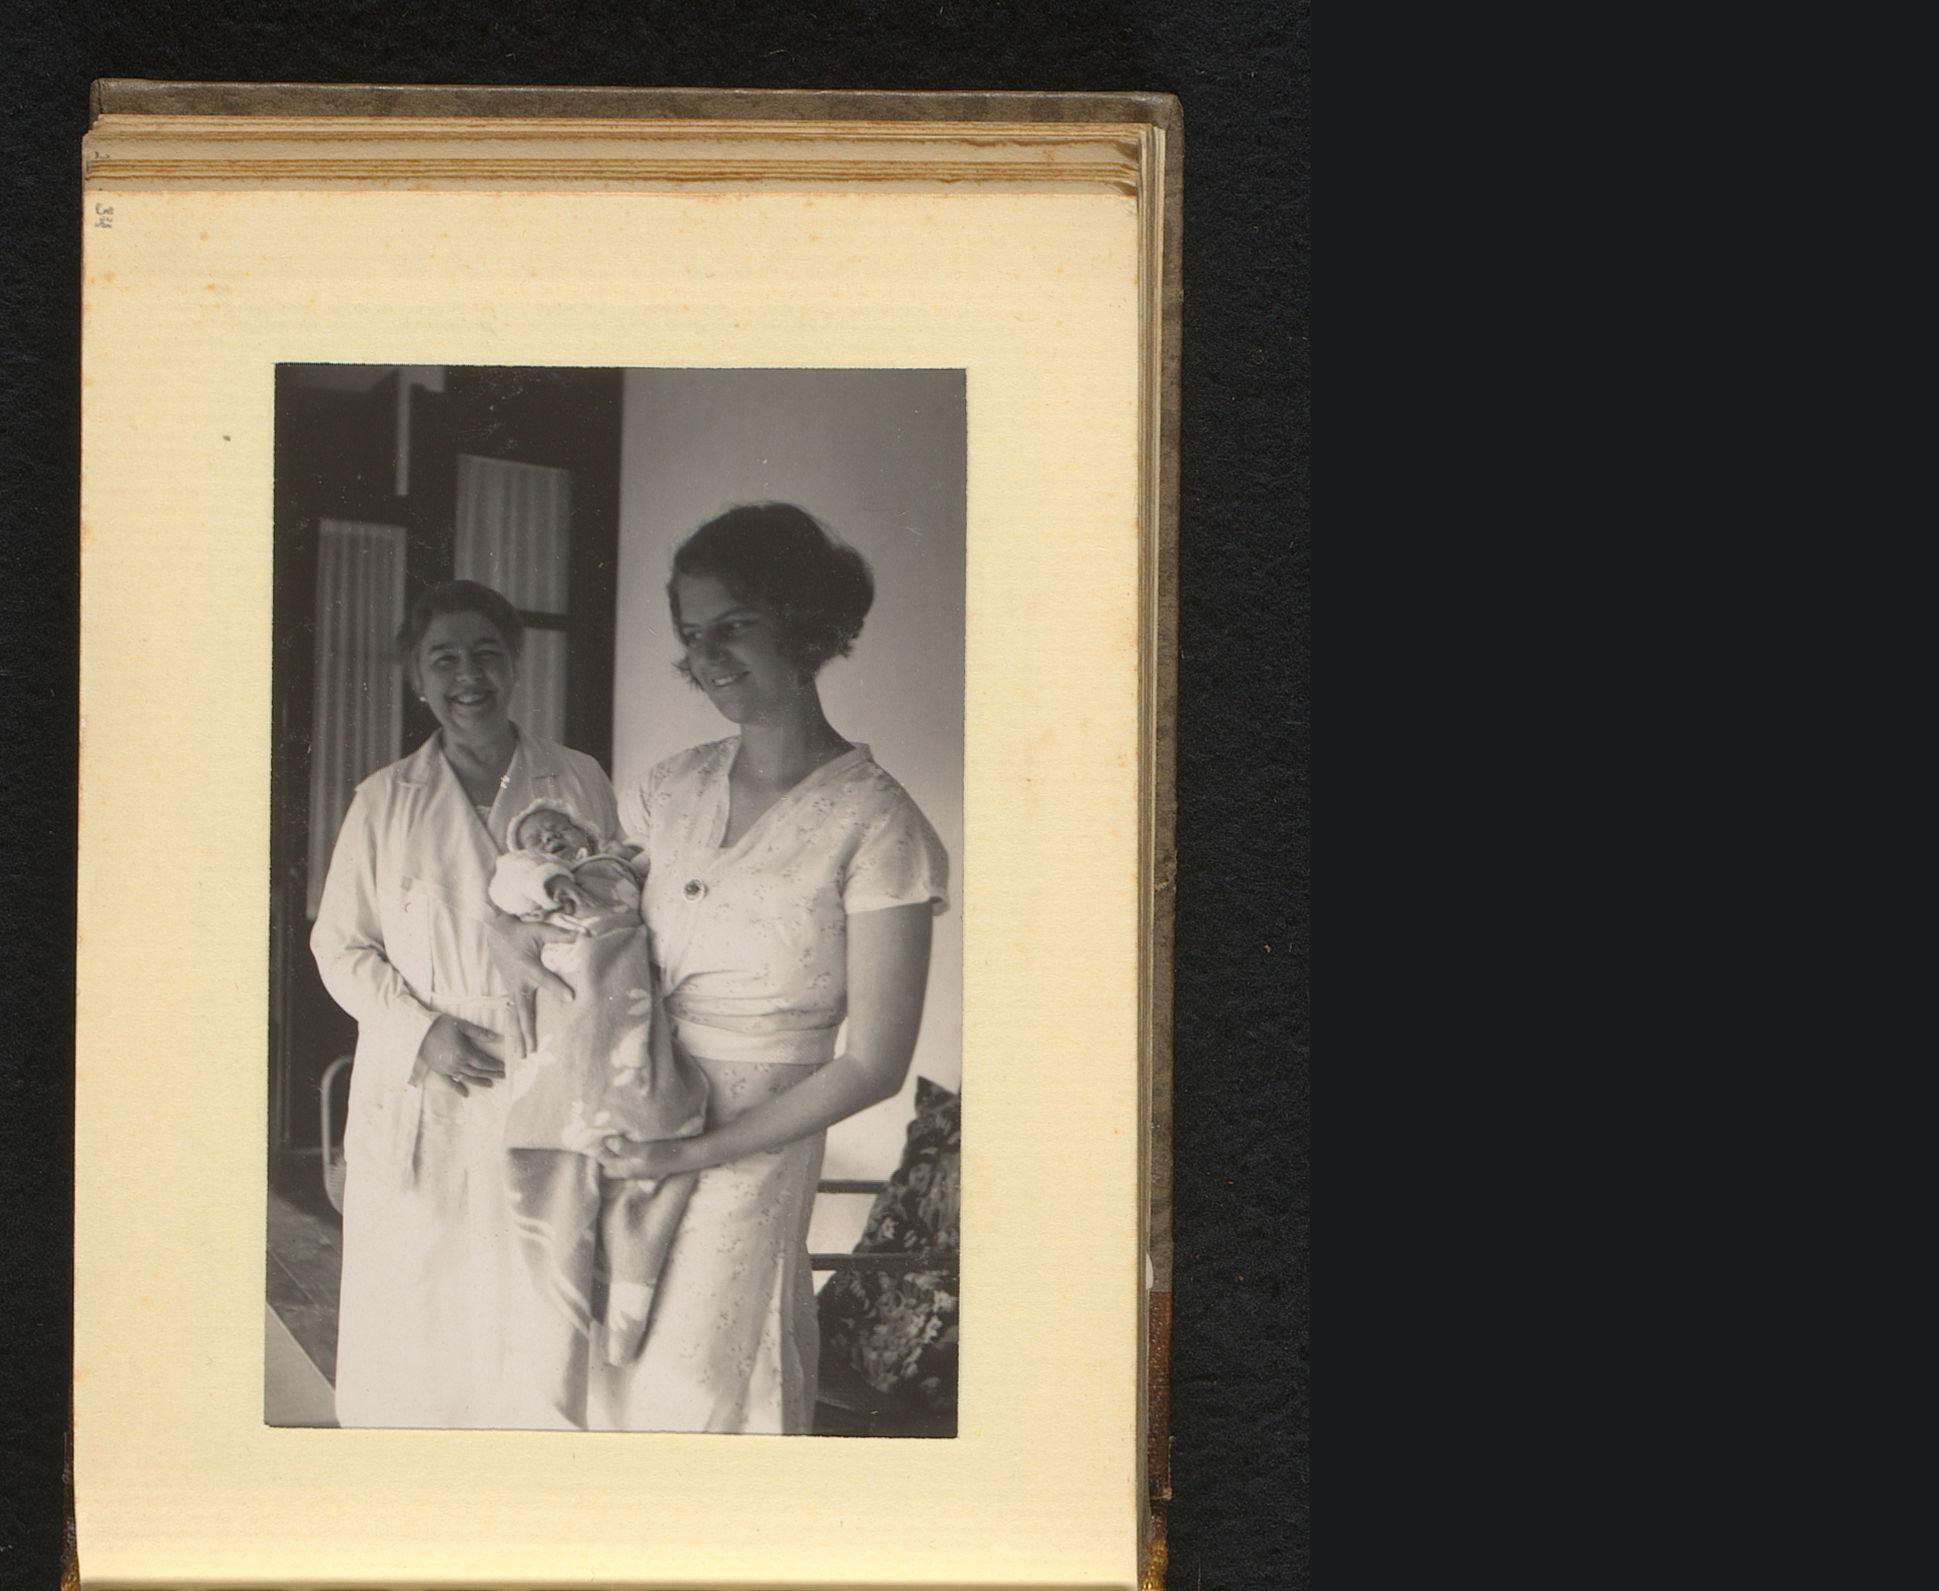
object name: photograph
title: Twee vrouwen en een baby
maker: norbert van den berg (1901-1972)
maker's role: amateurfotograaf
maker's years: 1901-1972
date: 1935-1950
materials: paper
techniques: gelatin silver print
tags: adult woman, infant, baby